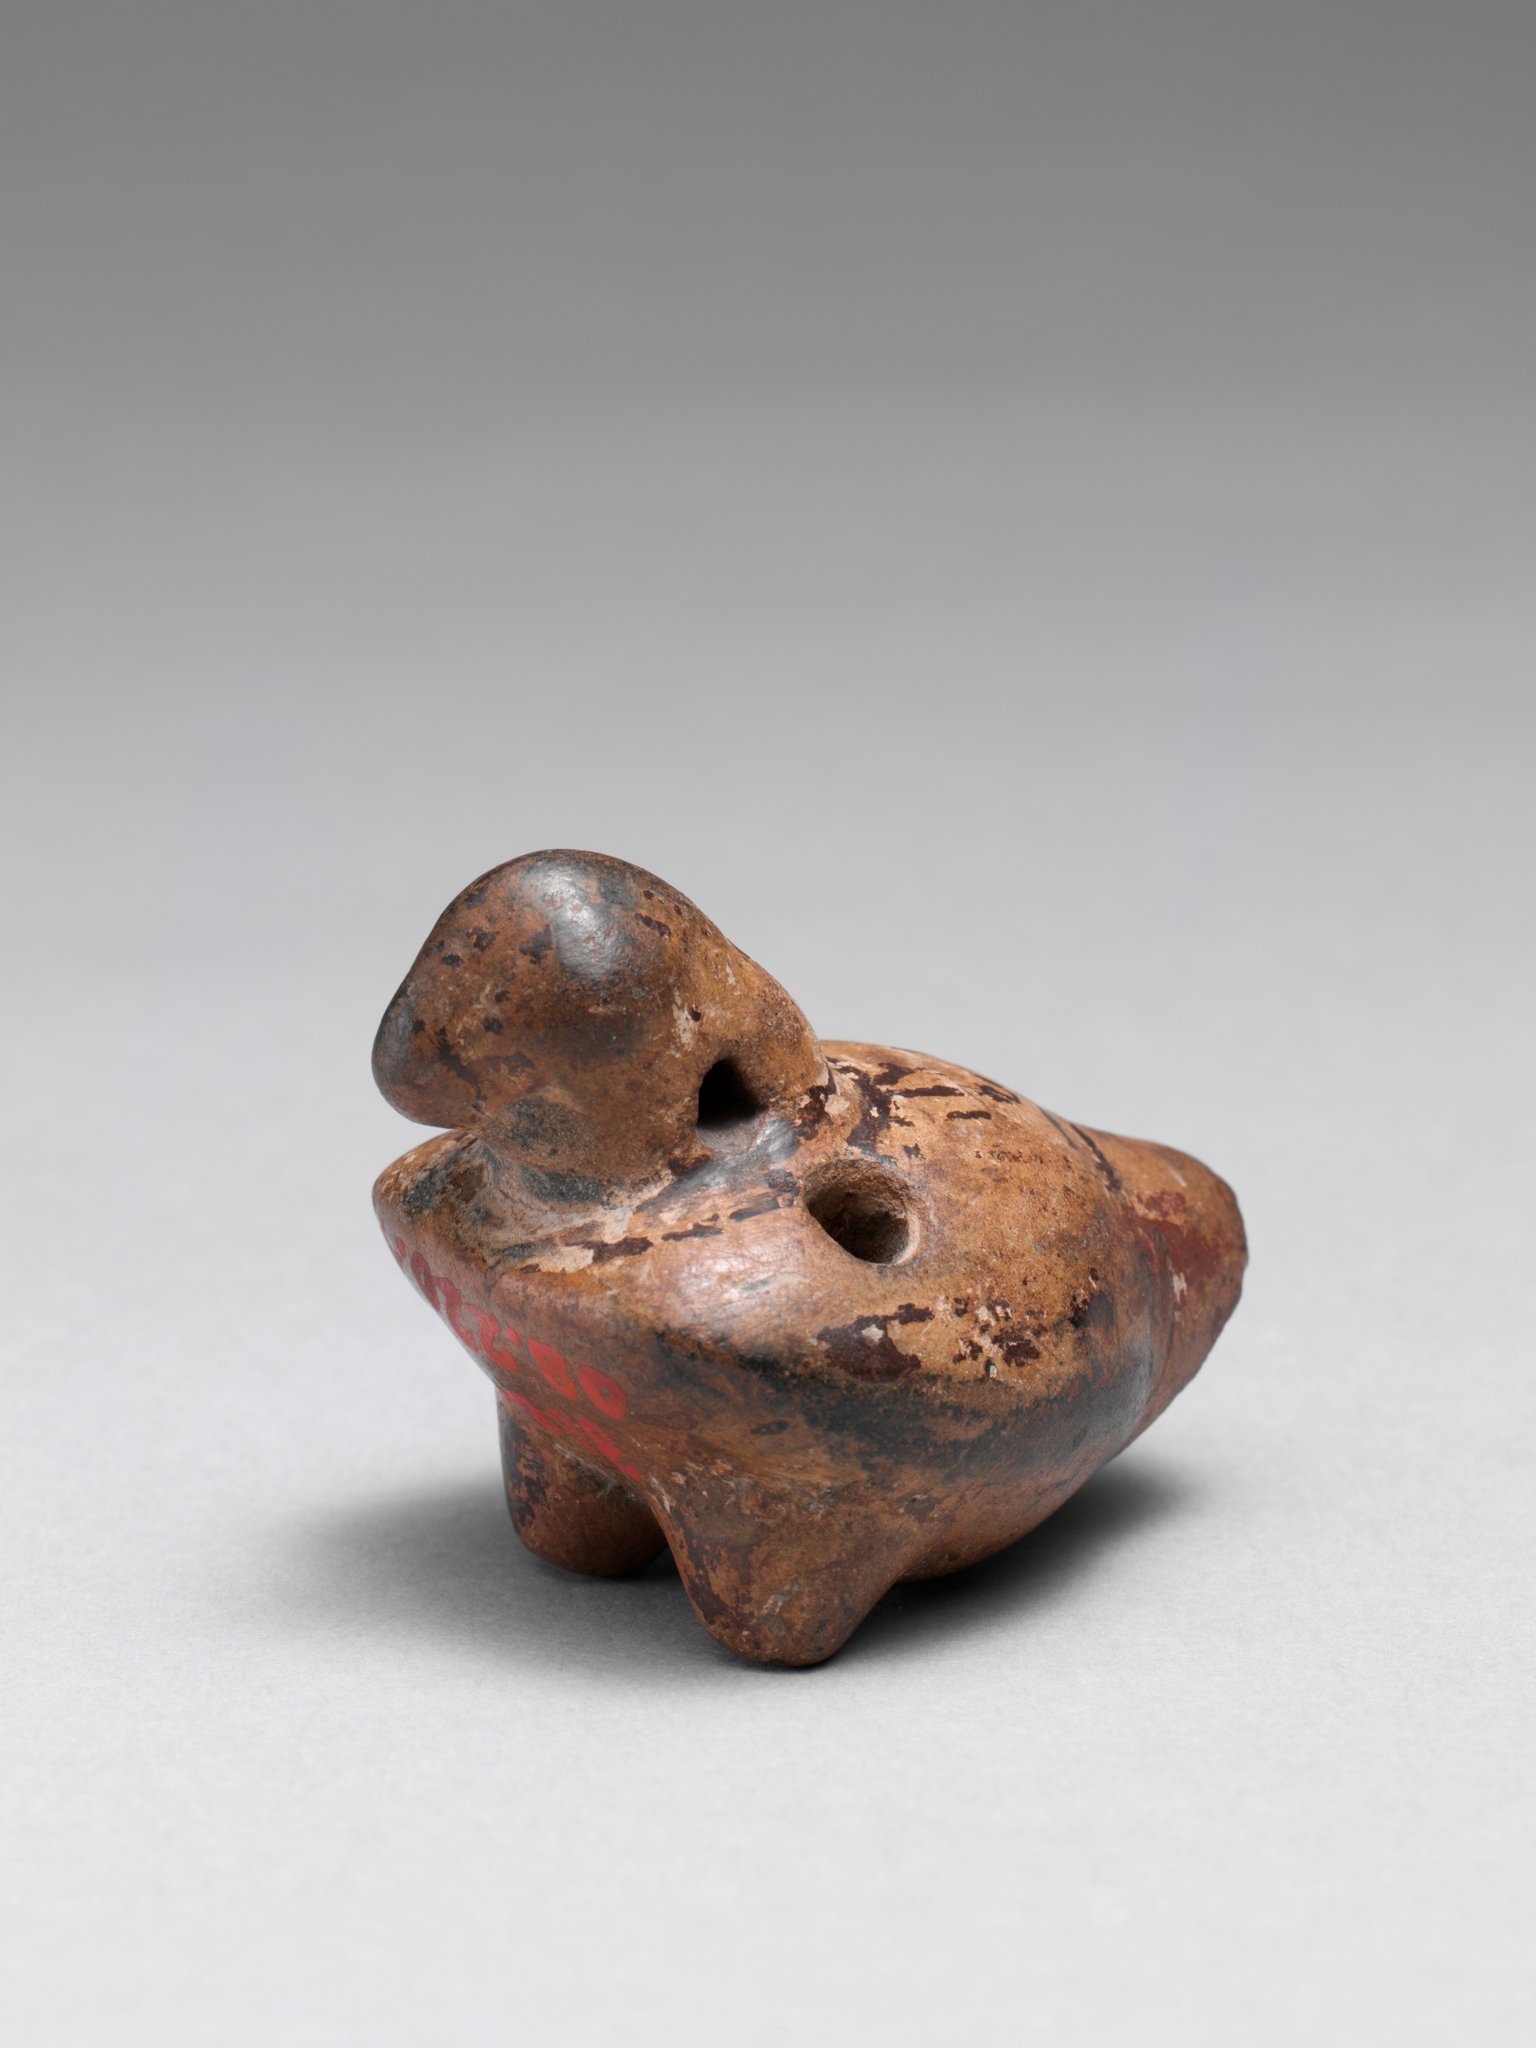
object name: pottery whistle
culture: costa rican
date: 800-1525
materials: clay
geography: costa rica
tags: birds